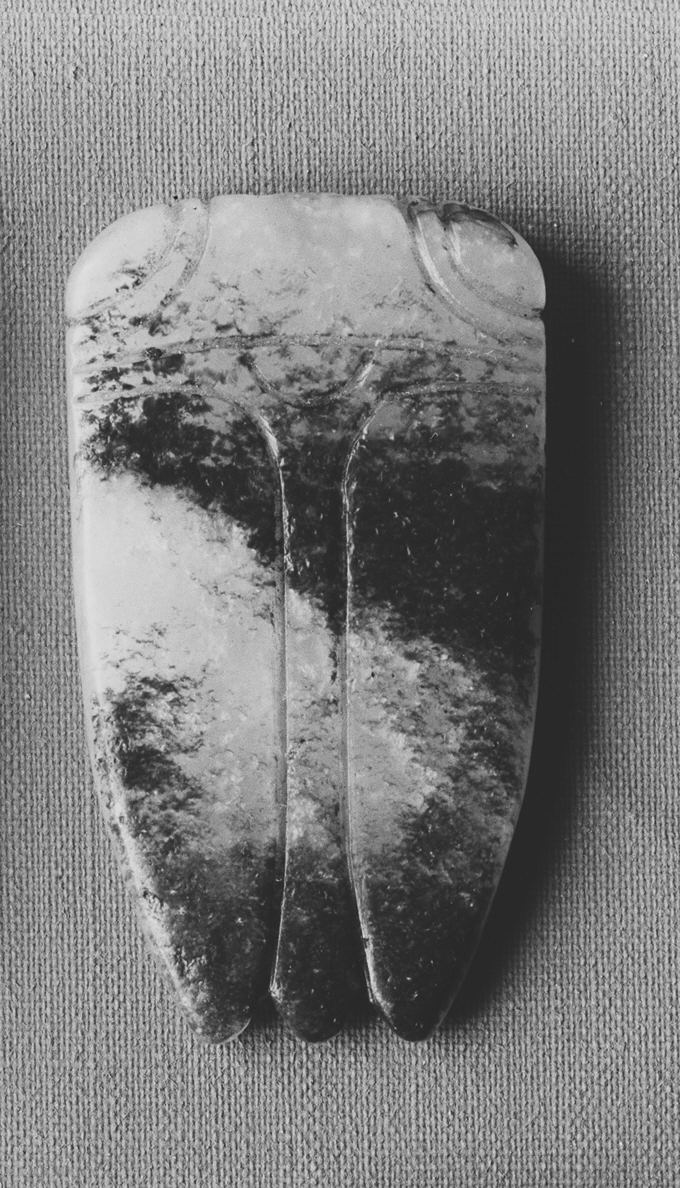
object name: necklace, bead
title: Cicada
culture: chinese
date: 206 BCE-220 CE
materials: jade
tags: insects